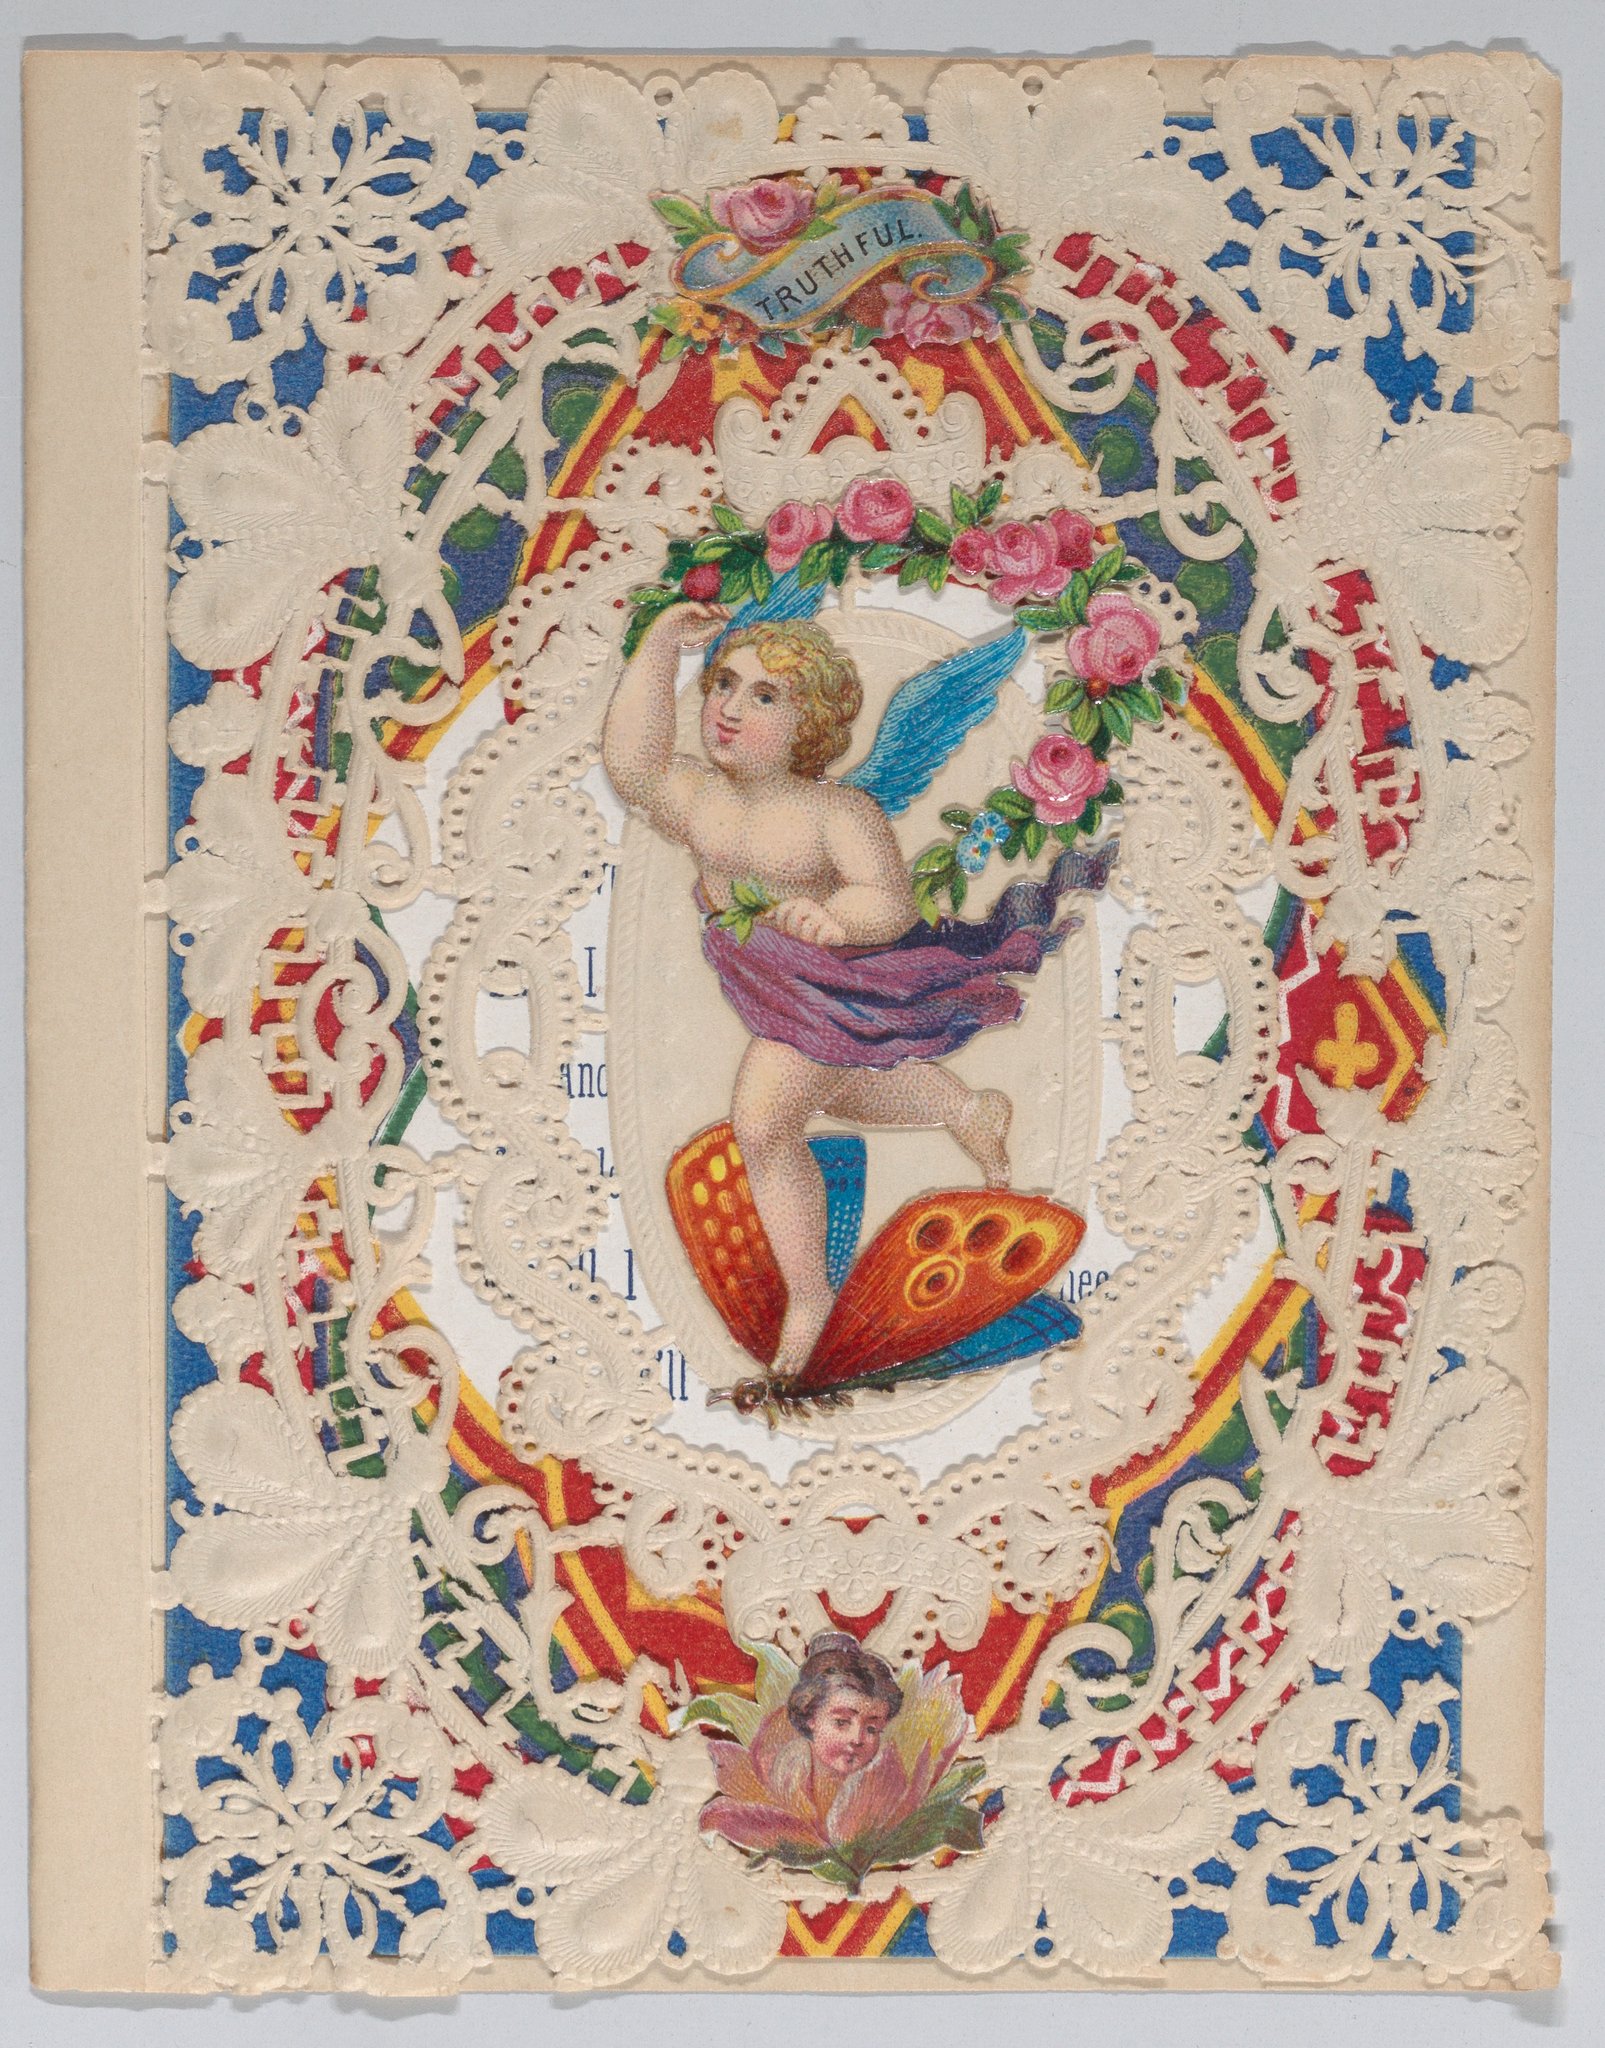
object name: valentine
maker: Anonymous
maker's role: artist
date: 1880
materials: lace, paper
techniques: chromolithography, cutting, embossing, open work